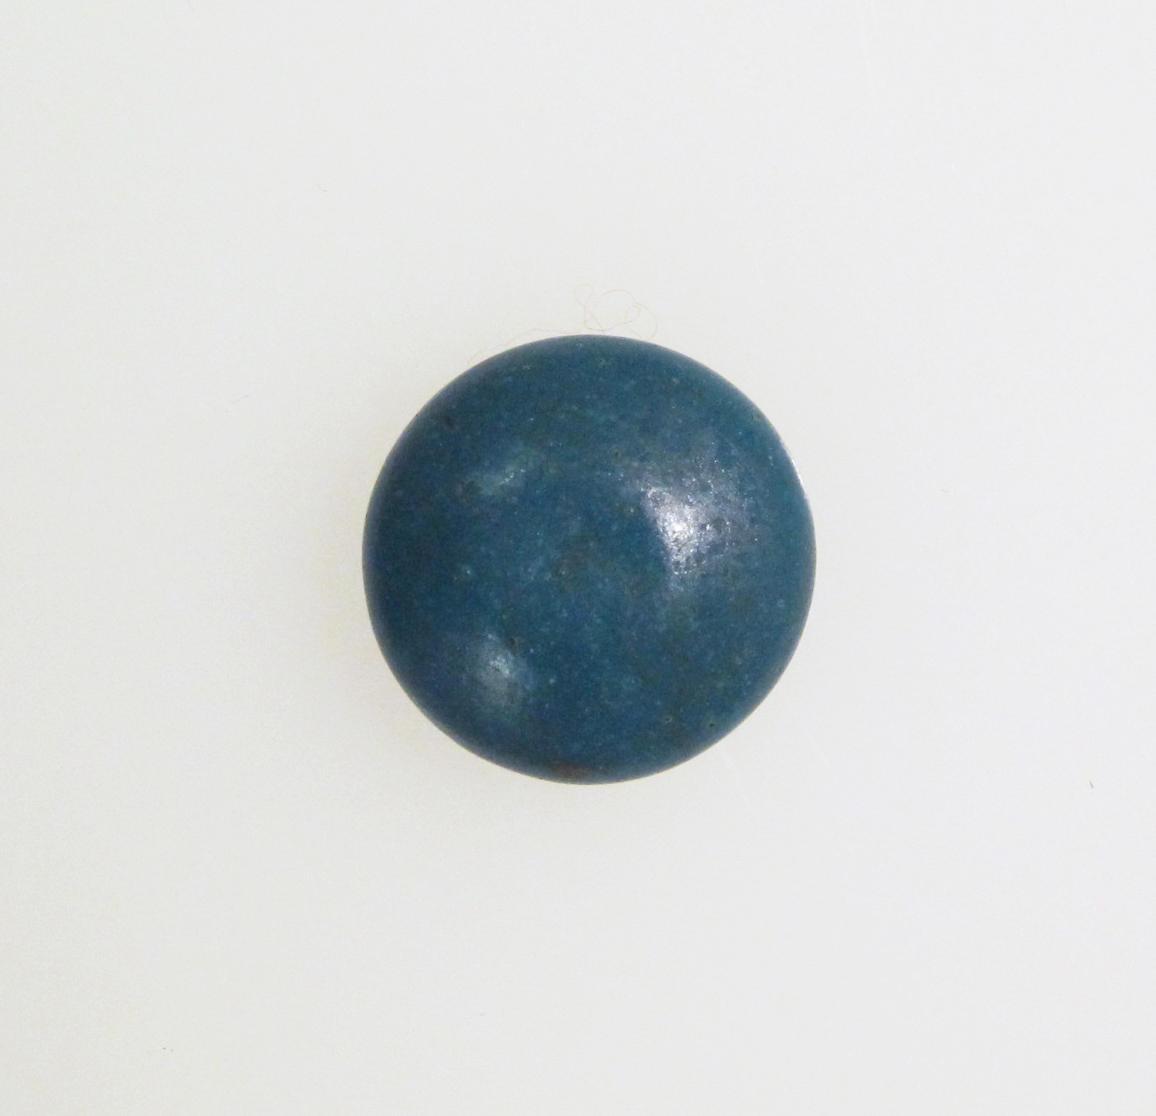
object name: pinhead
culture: roman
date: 100 BCE-500 CE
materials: glass